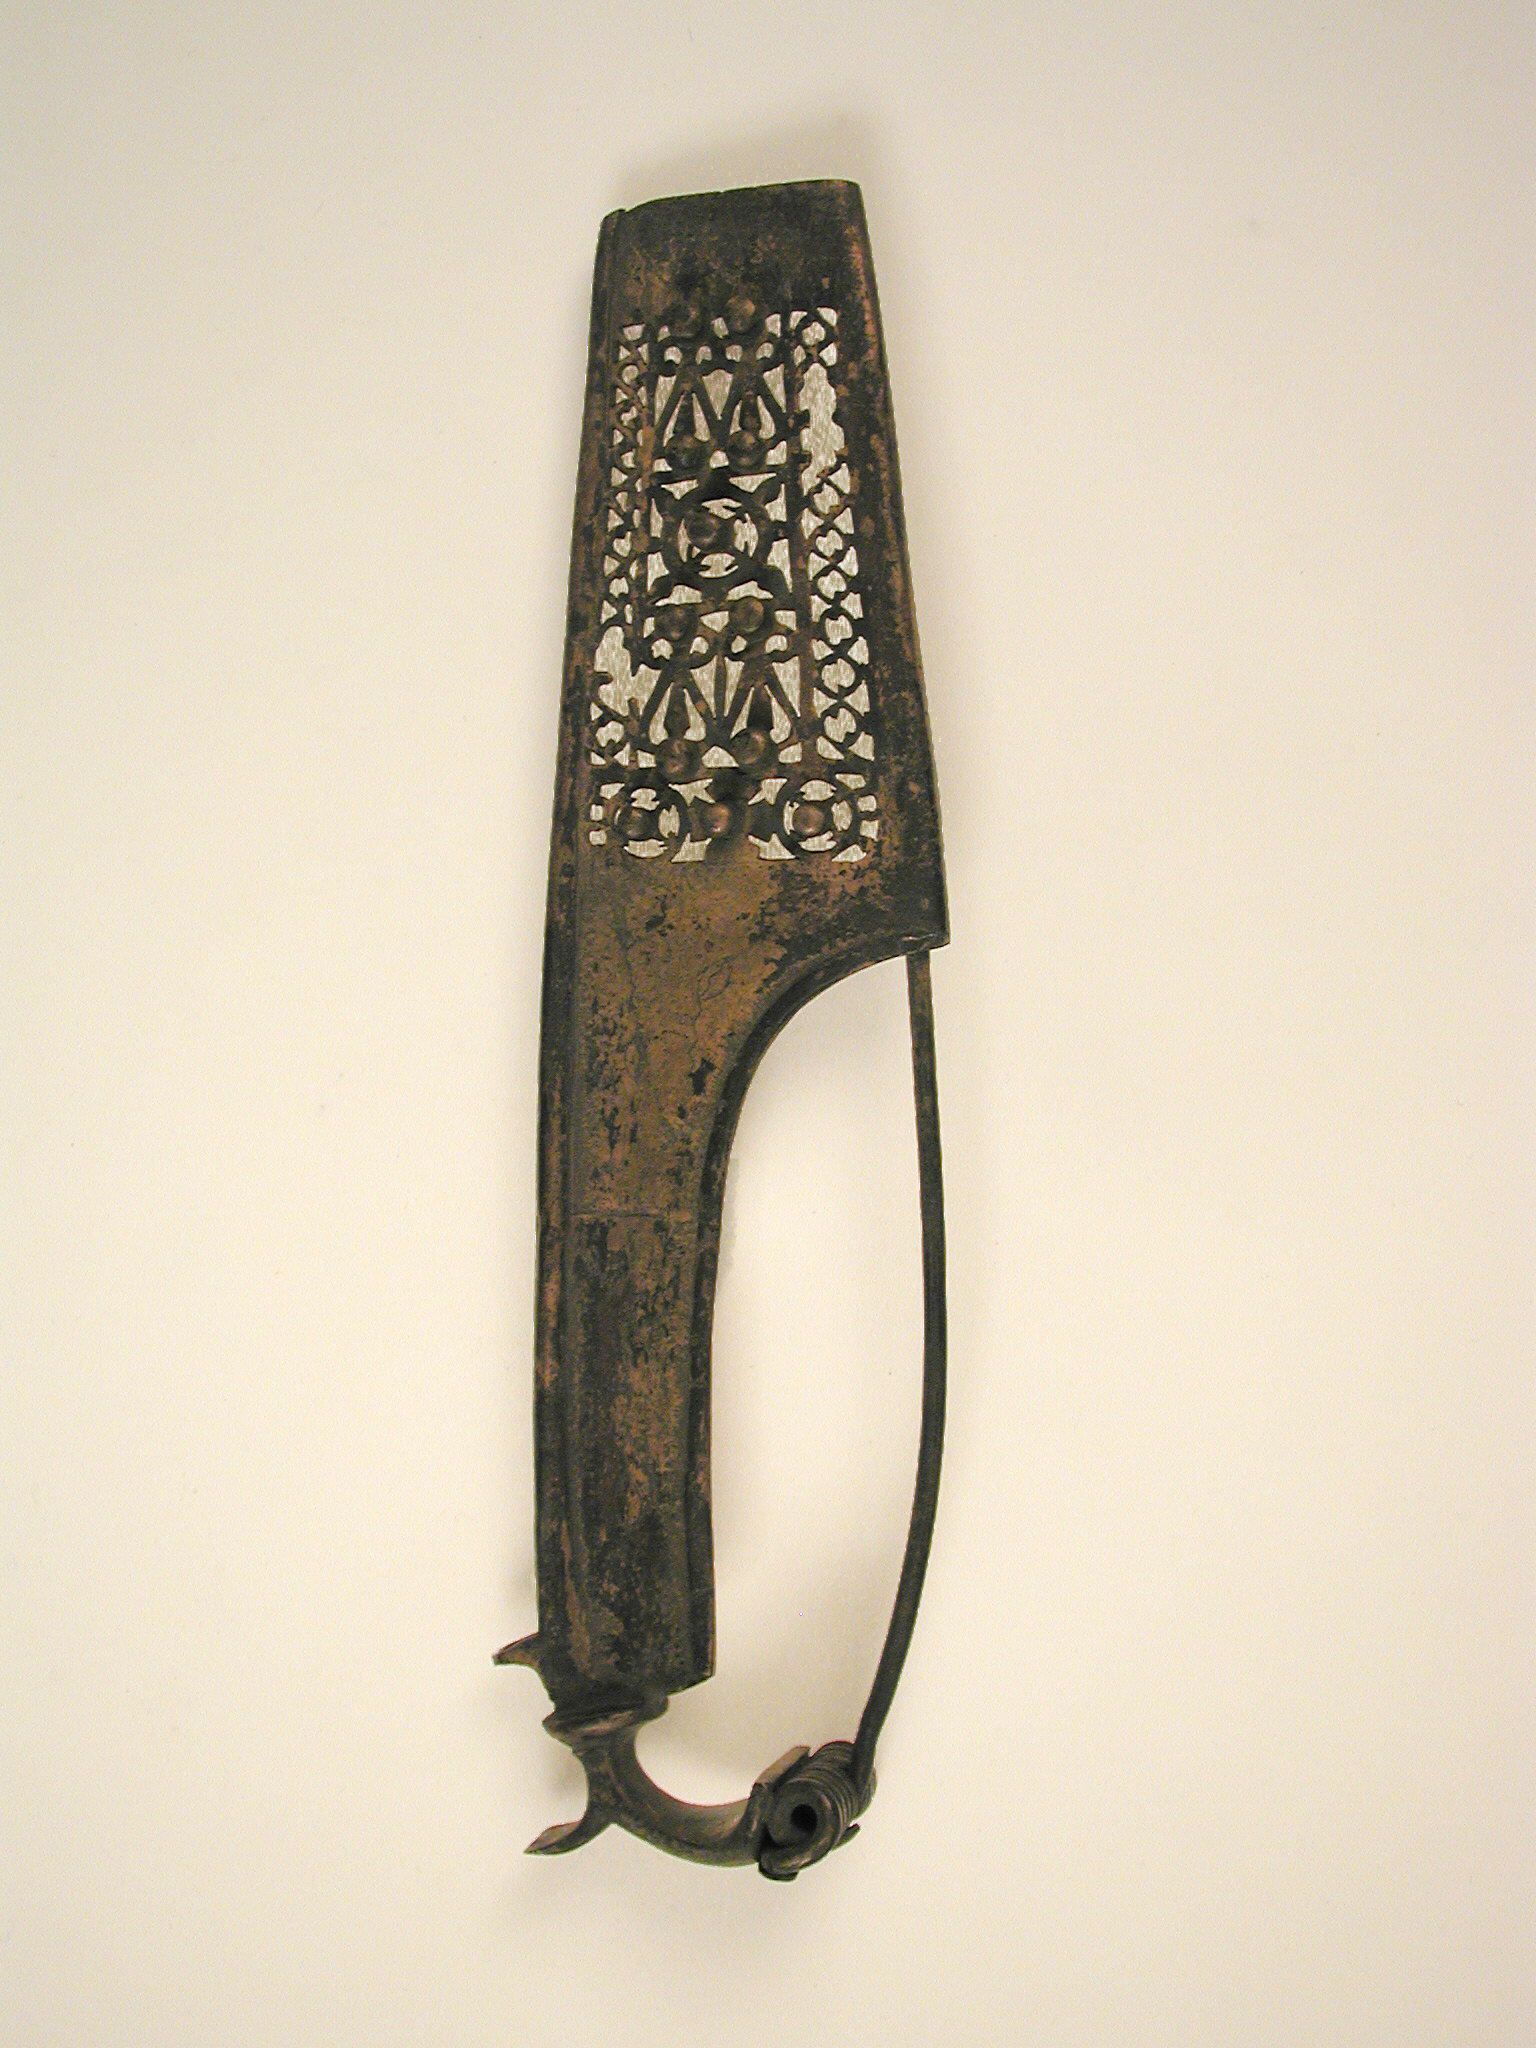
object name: brooch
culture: hungarian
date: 1901-1933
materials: silver gilt